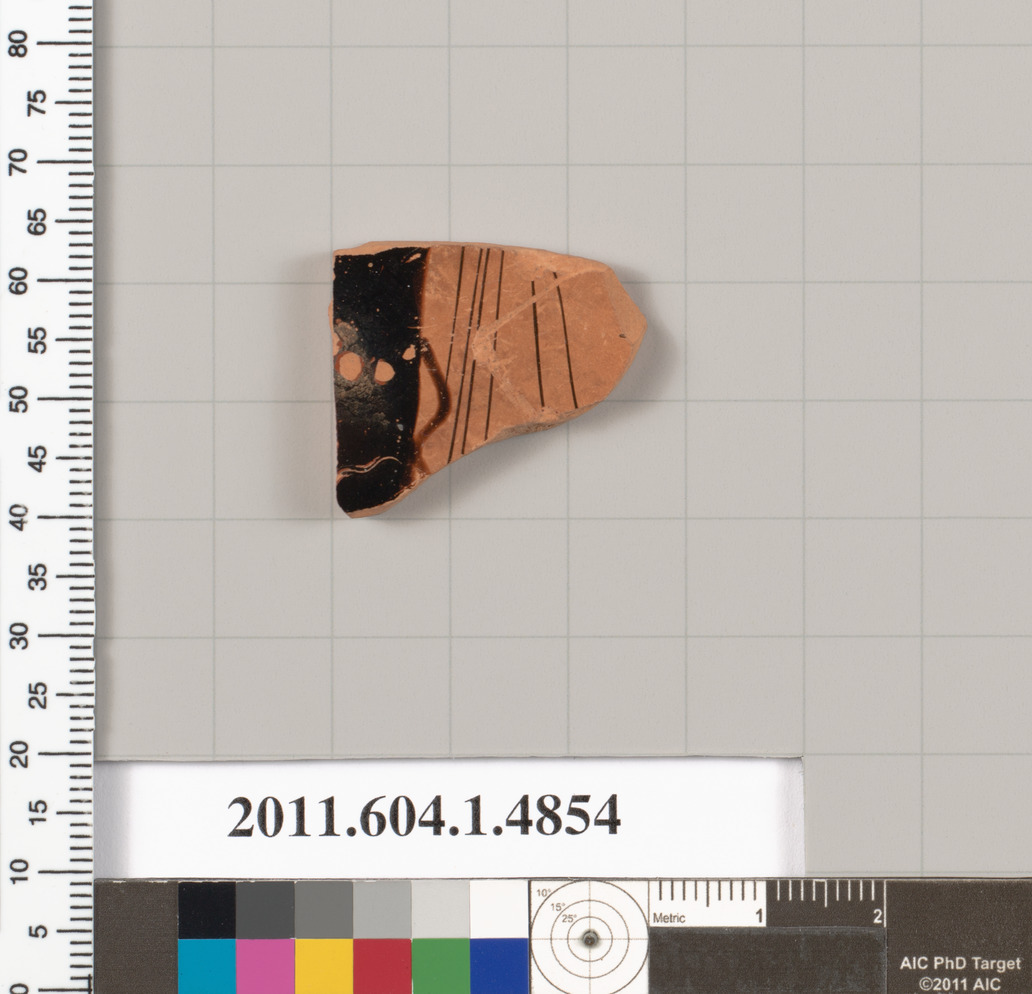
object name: kylix fragment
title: Terracotta fragment of a kylix (drinking cup)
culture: greek, attic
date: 475-451 BCE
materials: terracotta